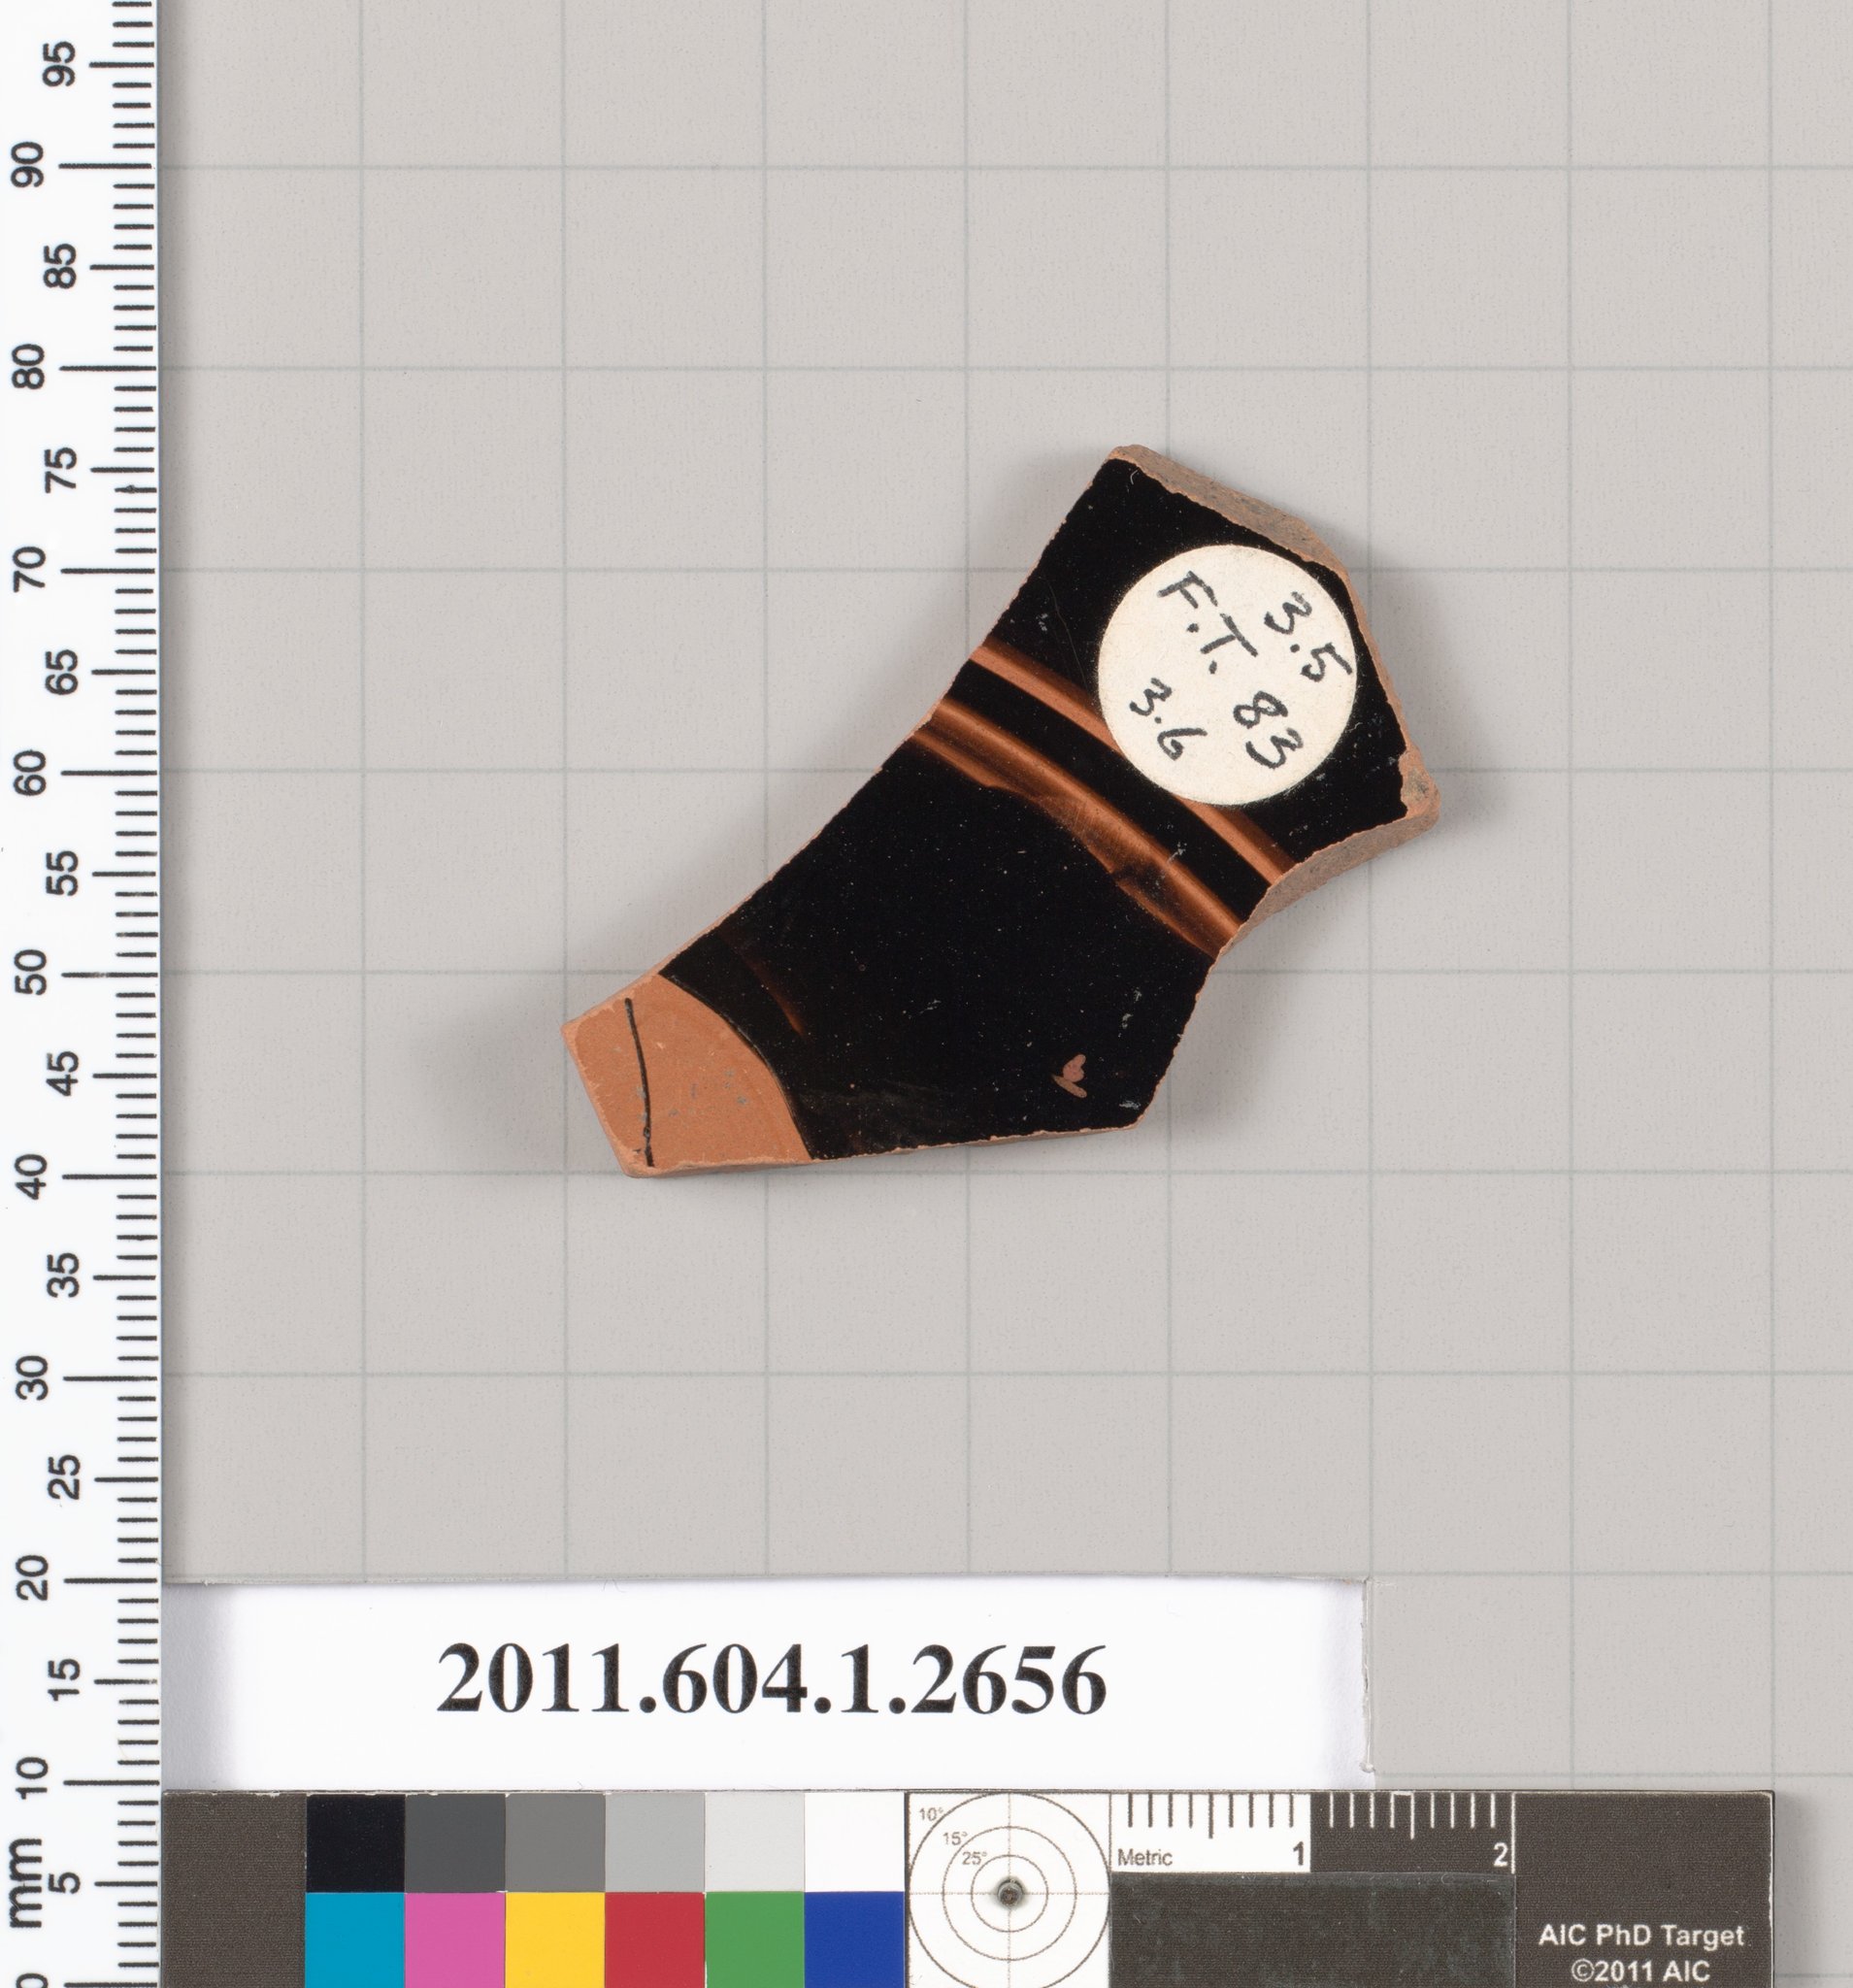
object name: kylix fragment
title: Terracotta fragment of a kylix (drinking cup)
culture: greek, attic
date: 500-451 BCE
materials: terracotta